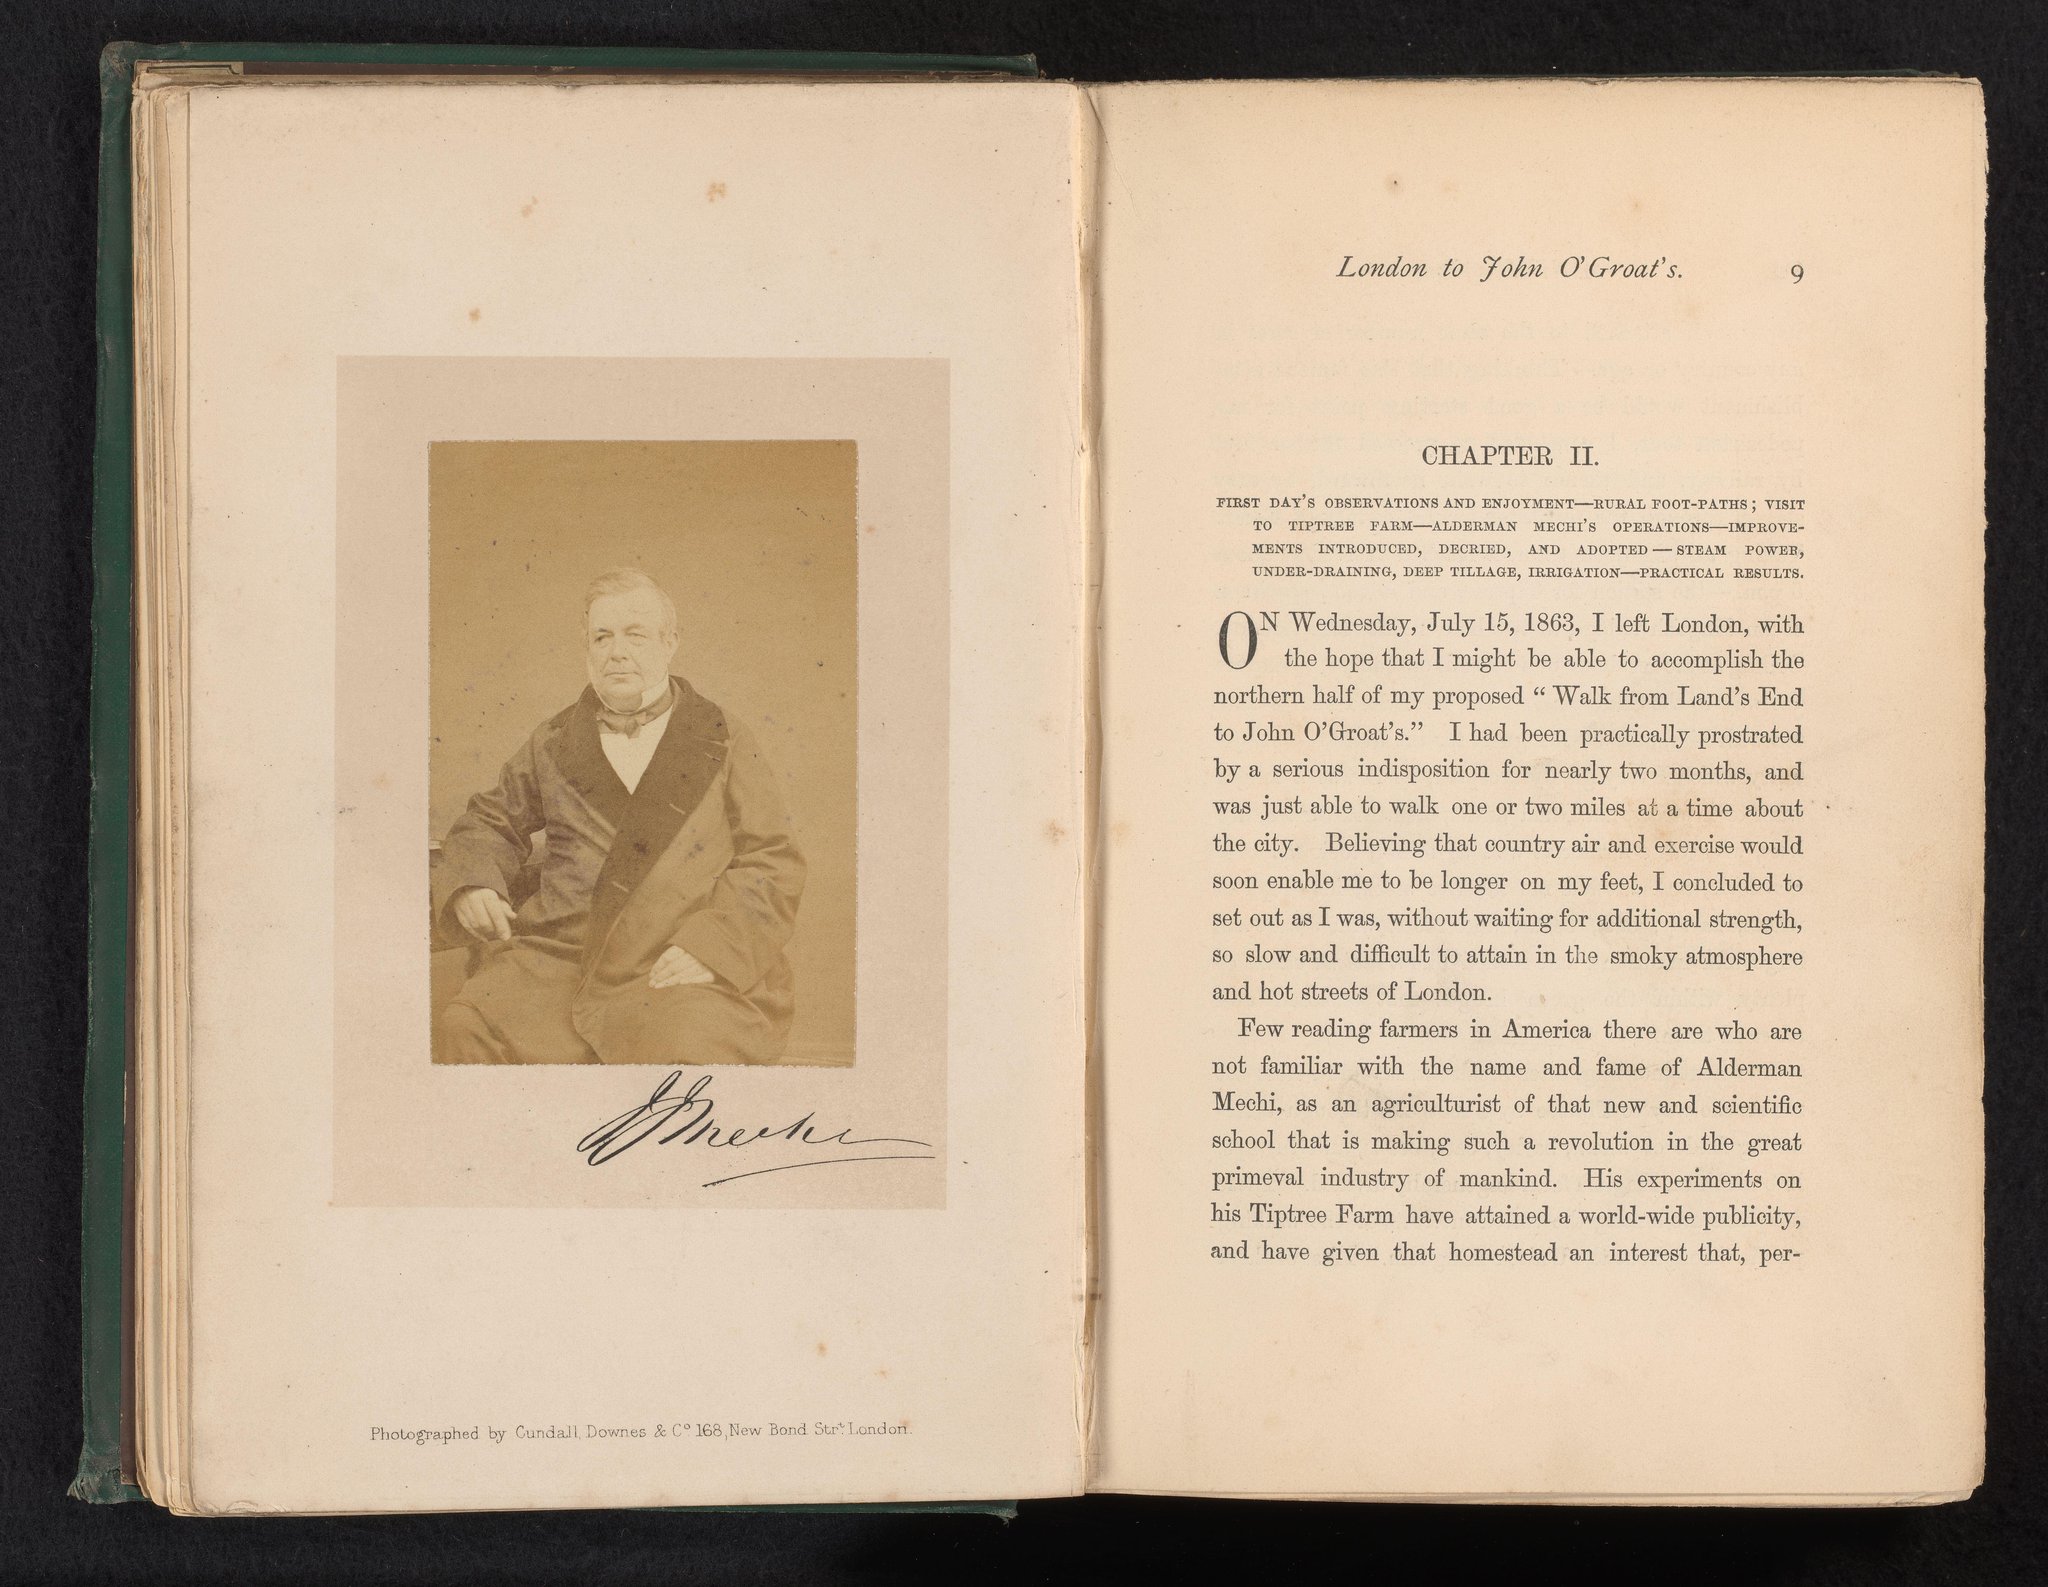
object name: page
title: Portret van de zilversmid, uitvinder en bankier John Joseph Mechi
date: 1859-1864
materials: paper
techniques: albumen print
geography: london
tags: silversmith, historical persons, smith, blacksmith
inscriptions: inscription: ‘Mechi’, address: ‘Photographed by Cundall Downes & Co. 168, New Bond Strt. London.’